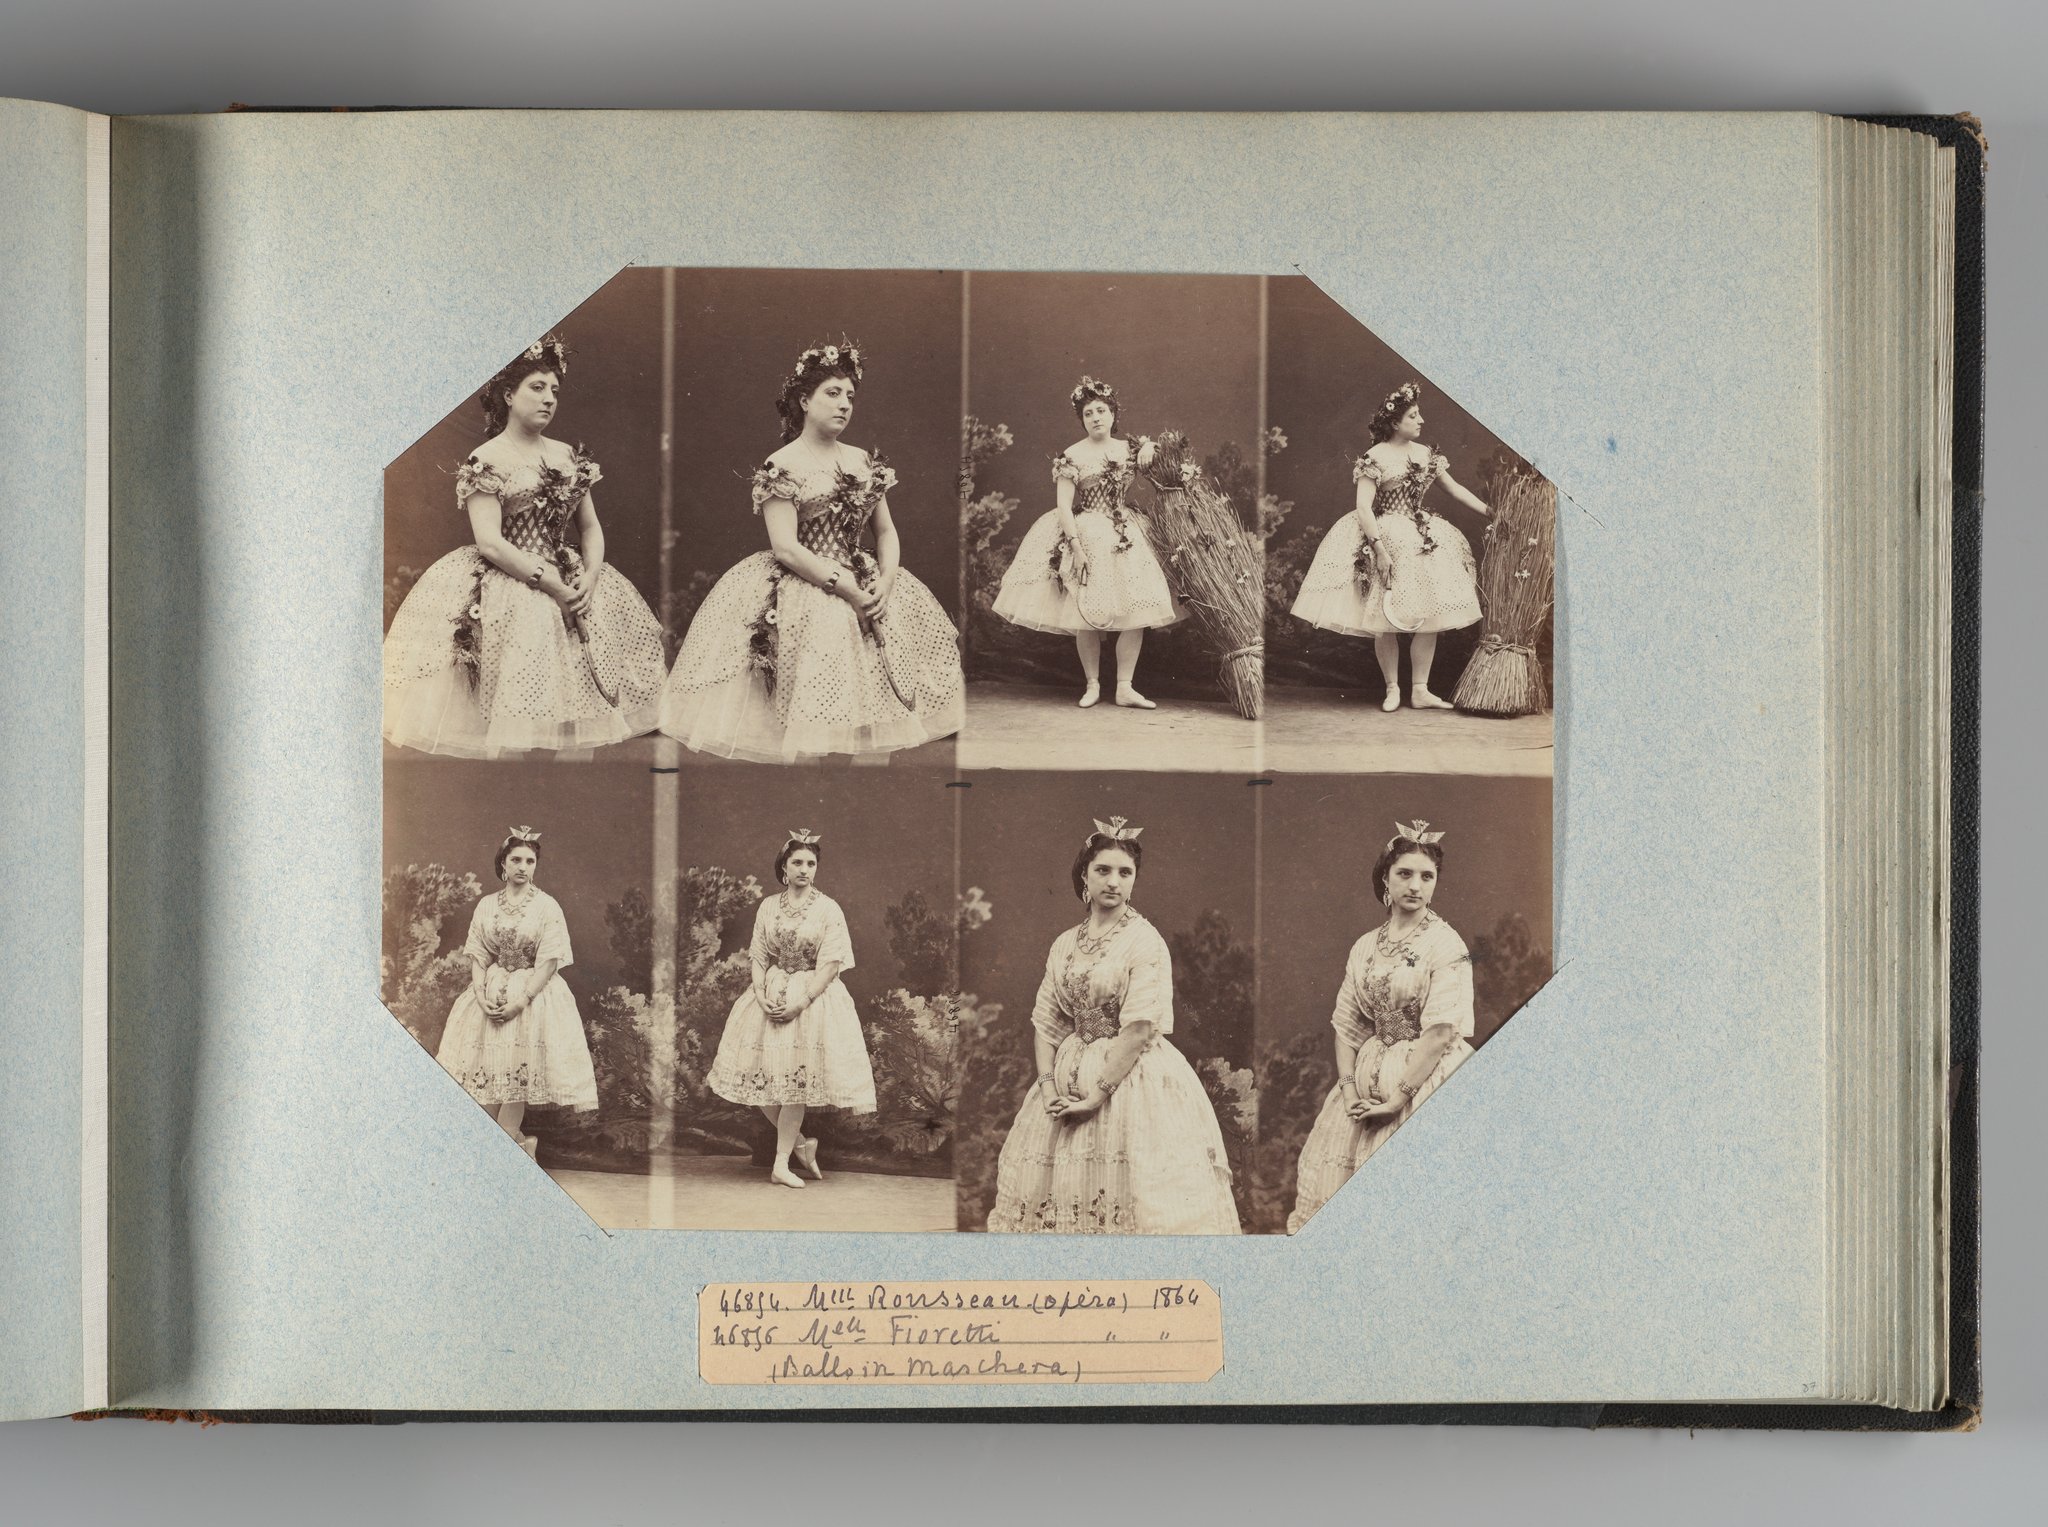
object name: photograph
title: Mlle Rousseau; Mlle Fioretti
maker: andré-adolphe-eugène disdéri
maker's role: artist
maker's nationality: french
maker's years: 1819-1889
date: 1864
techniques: albumen silver print, glass negative